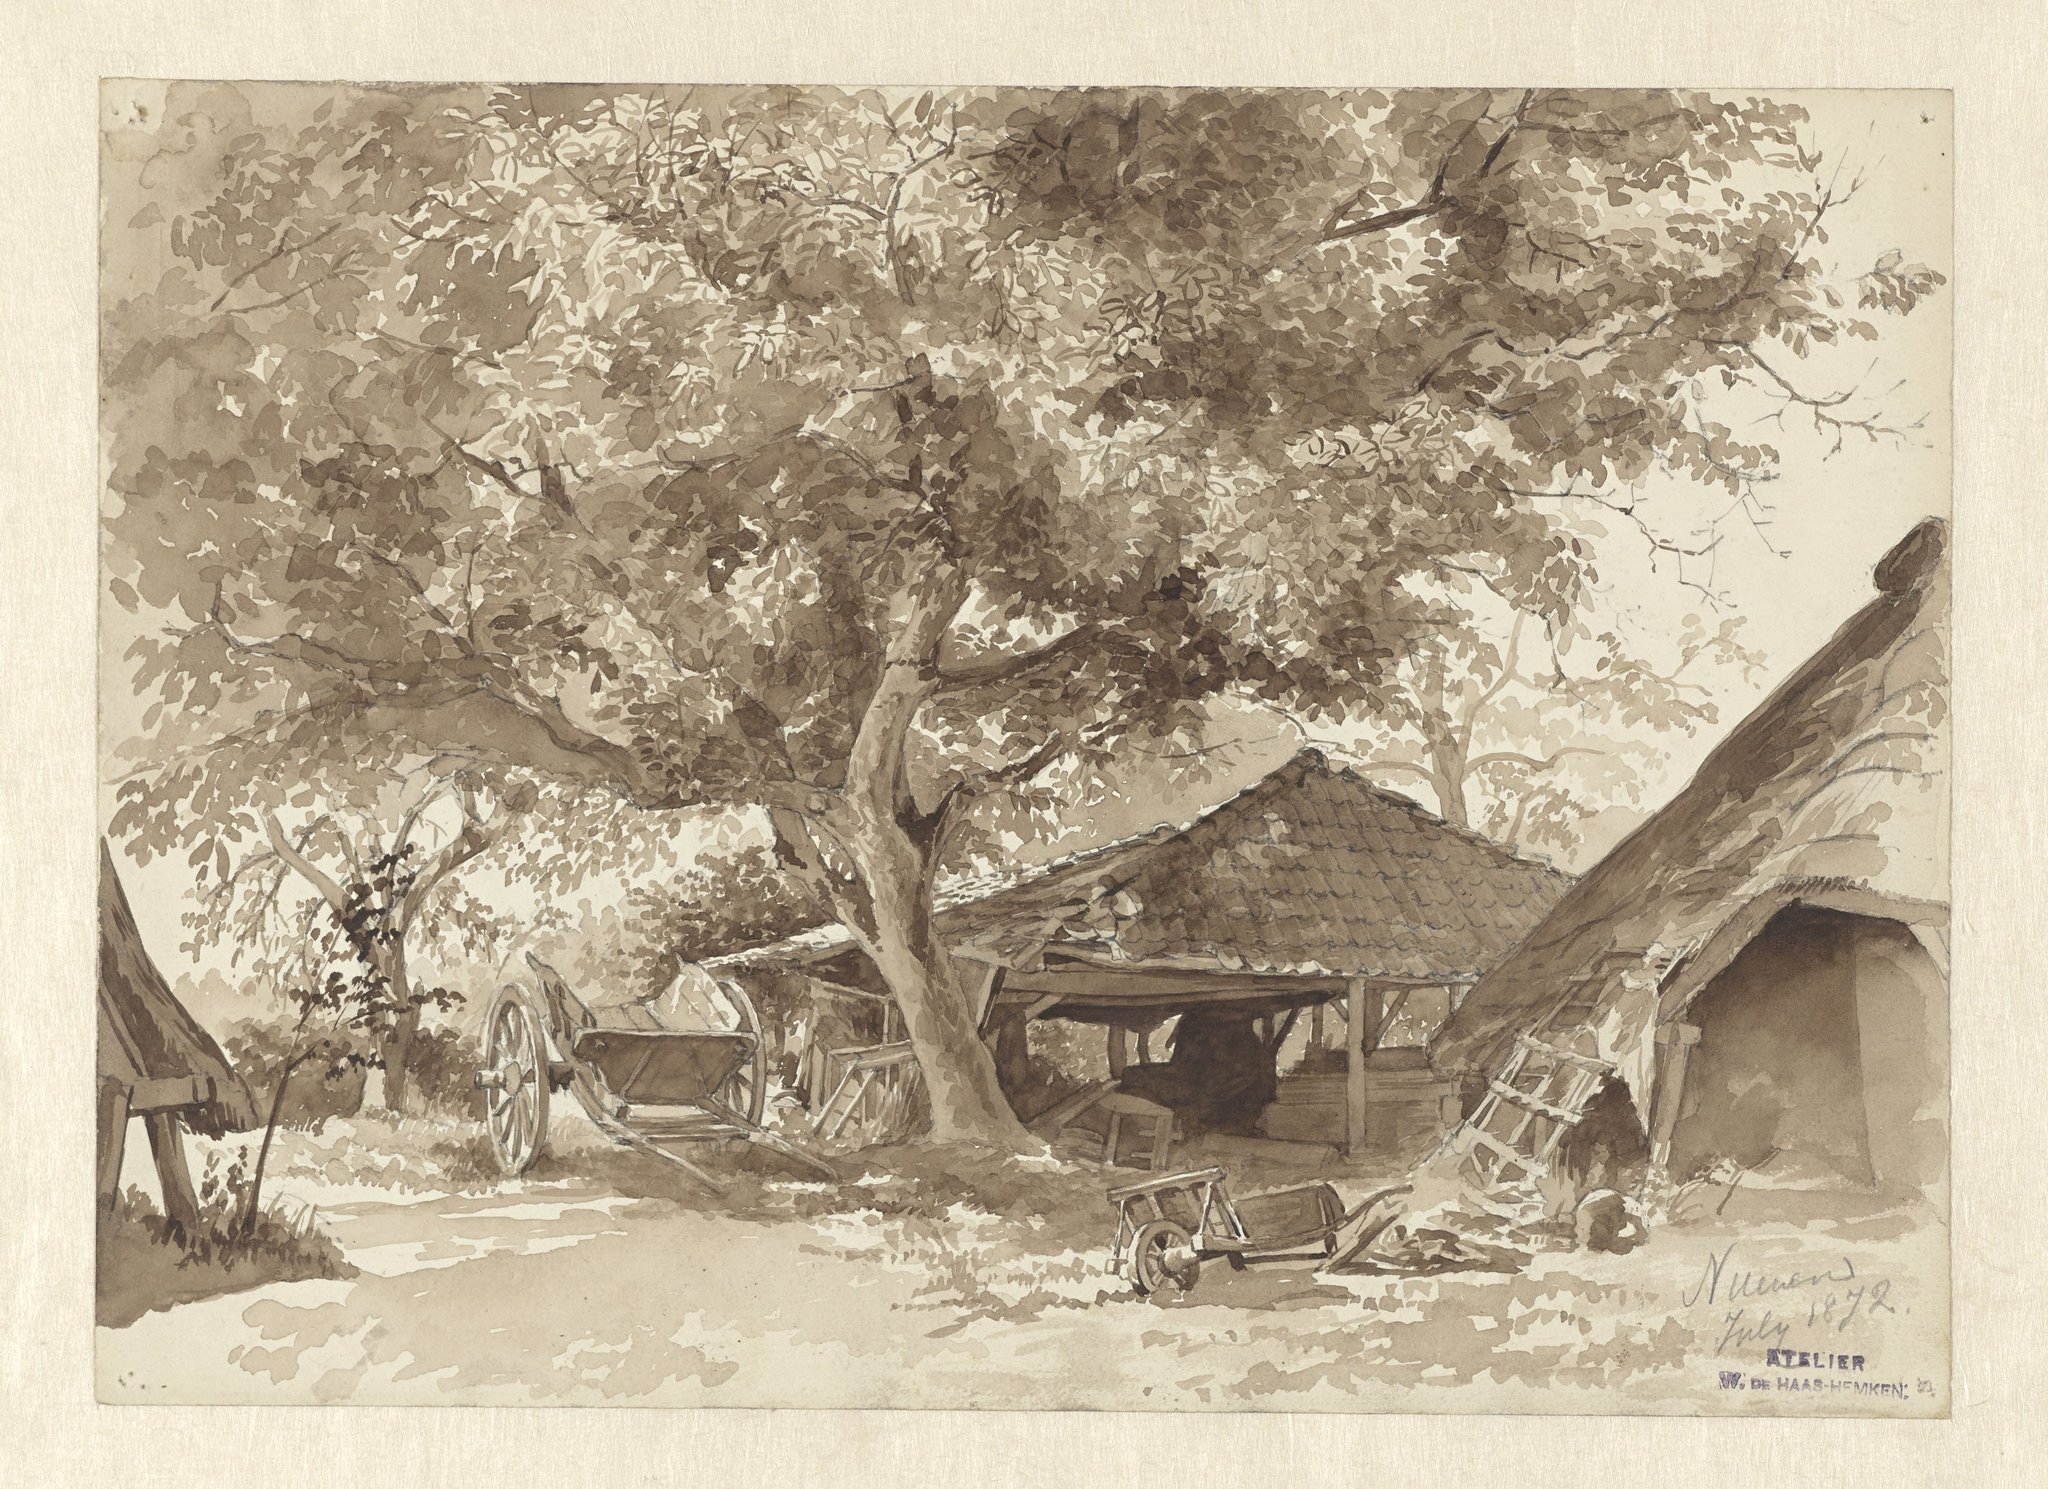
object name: drawing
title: Schuren onder hoog geboomte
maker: willem de haas hemken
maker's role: draughtsman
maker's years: 1831-1911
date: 1807-1872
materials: paper, pencil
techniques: brush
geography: nuenen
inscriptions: date: ‘July 1872’, workshop stamp, inscription: ‘Nuenen’